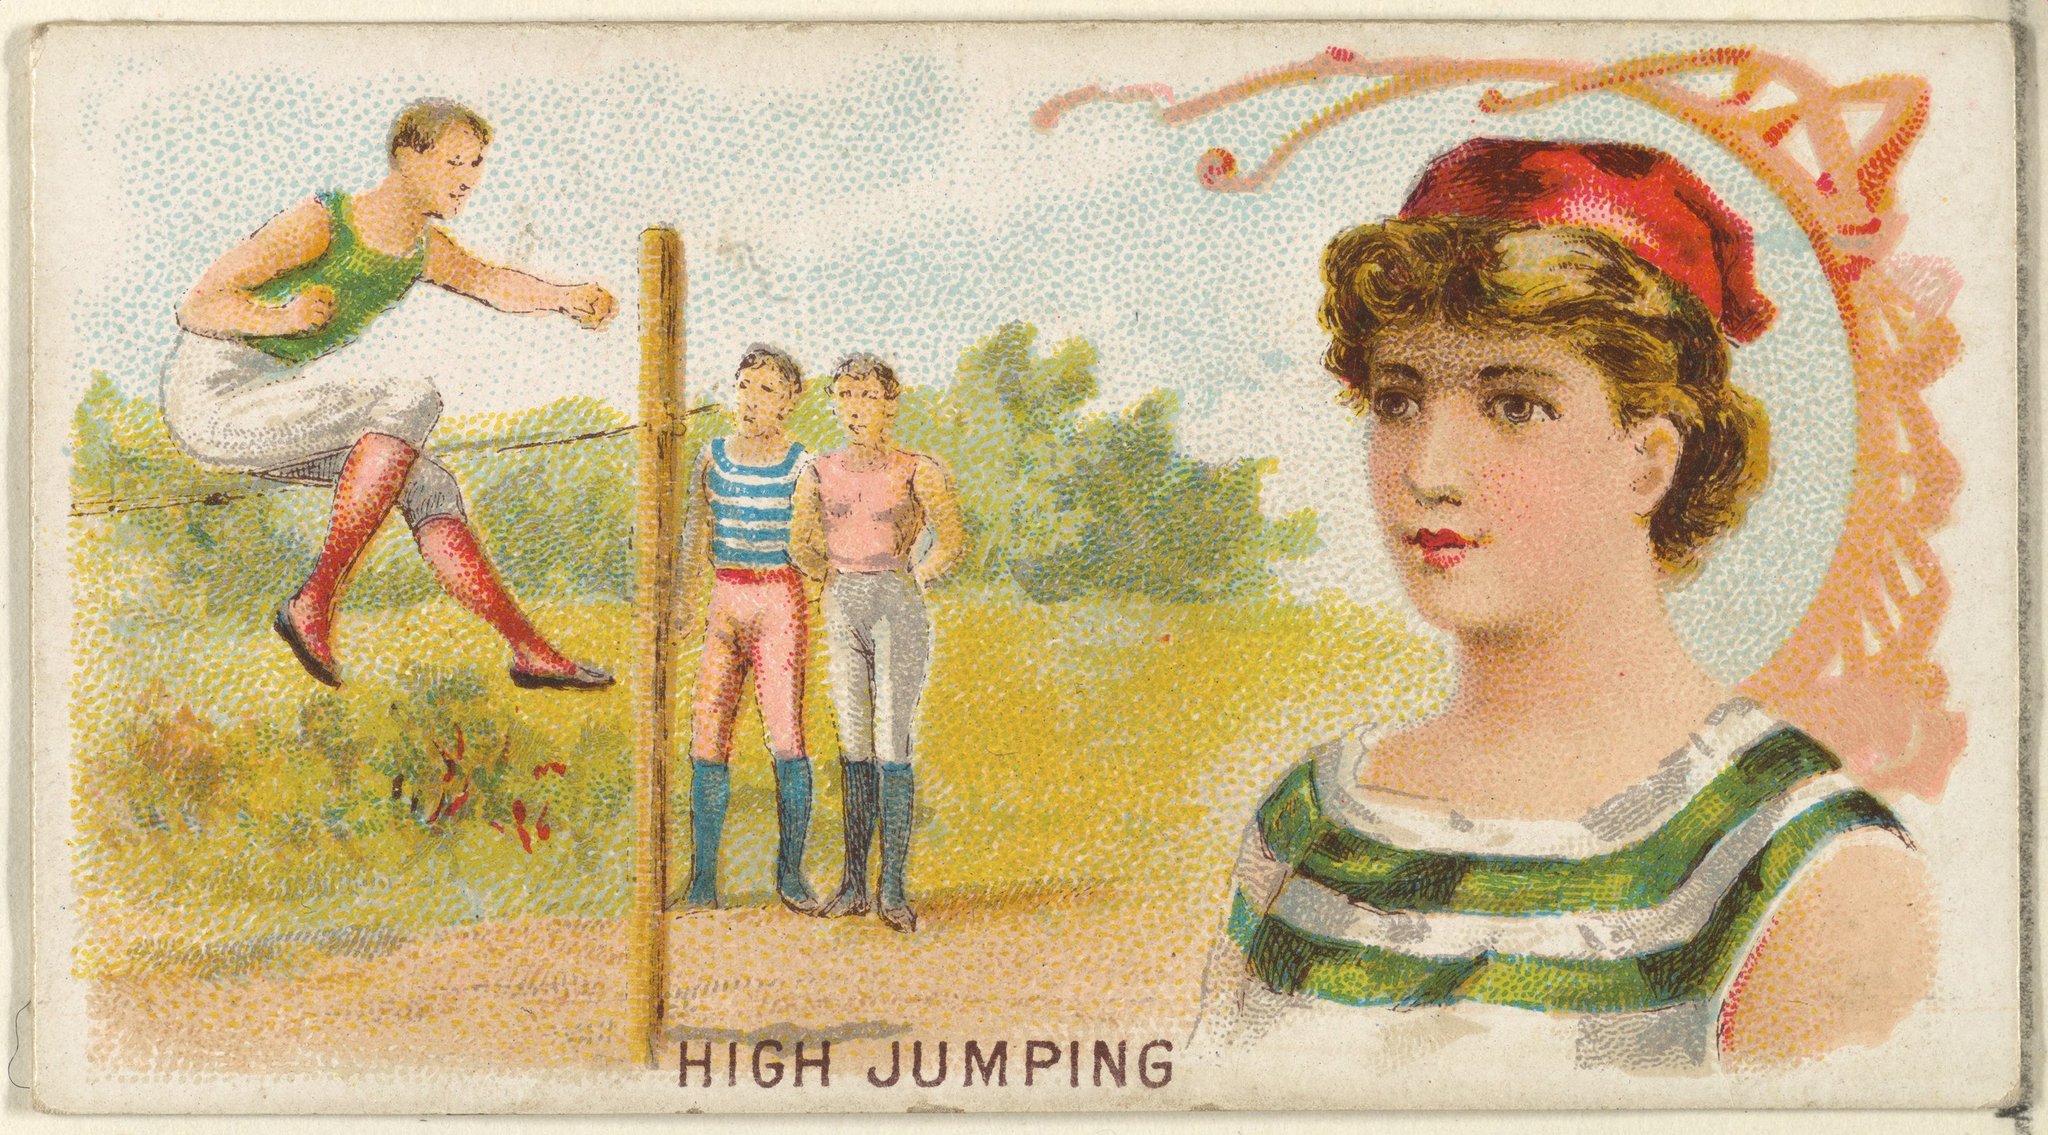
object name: print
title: High Jumping, from the Games and Sports series (N165) for Old Judge Cigarettes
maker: goodwin & company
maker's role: publisher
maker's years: 1850-1950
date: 1889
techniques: color lithograph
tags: men,women,sports,athletes